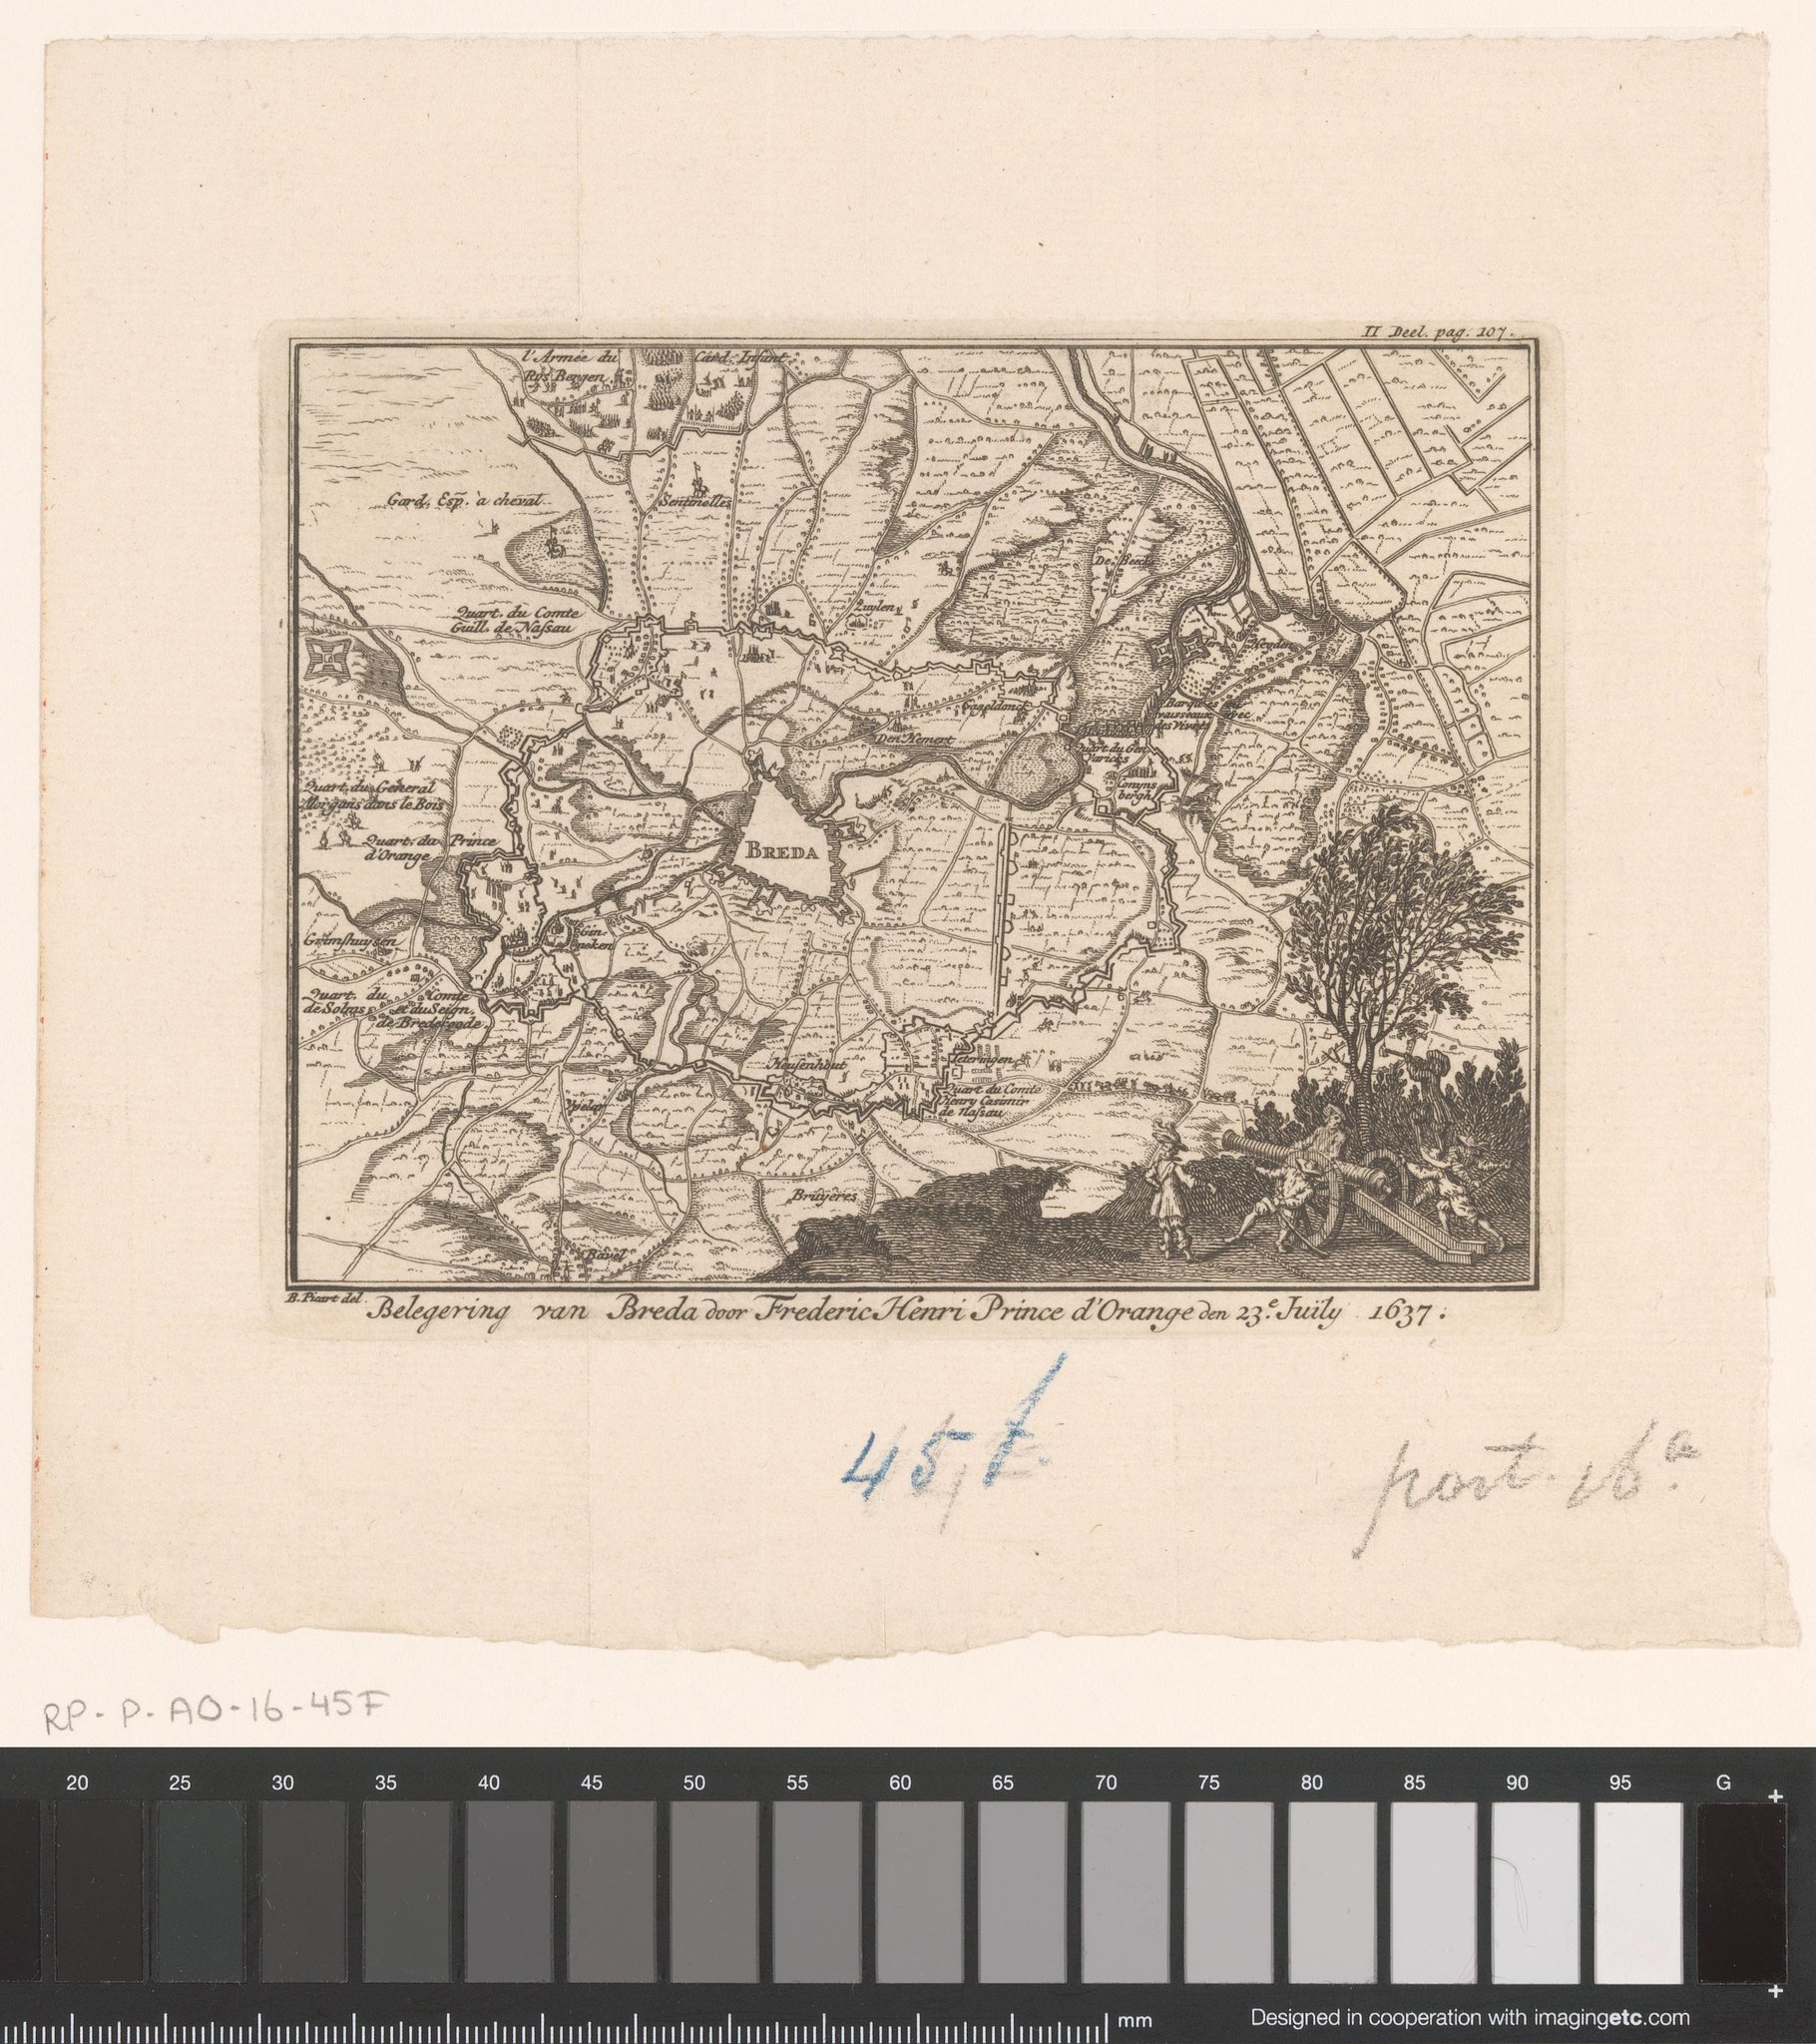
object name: print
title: Beleg van Breda door Frederik Hendrik van Oranje in 1637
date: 1737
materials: paper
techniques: engraving, etching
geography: amsterdam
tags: delft, frederick henry (prince of orange), maps of separate countries or regions, siege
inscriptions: collector's mark: Lugt 2228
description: Huidige staat van prent ook gebruikt in: Het leven van Frederik Hendrik, prins van Oranje (...). 2 delen. Den Haag: Ottho en Pieter van Thol, 1737, dl. 2, p. 107. Eerste staat van deze prent ook gebruikt in: Memoires de Frederic Henri de Nassau, prince d'Orange (...). Amsterdam: Pierre Humbert, 1733.